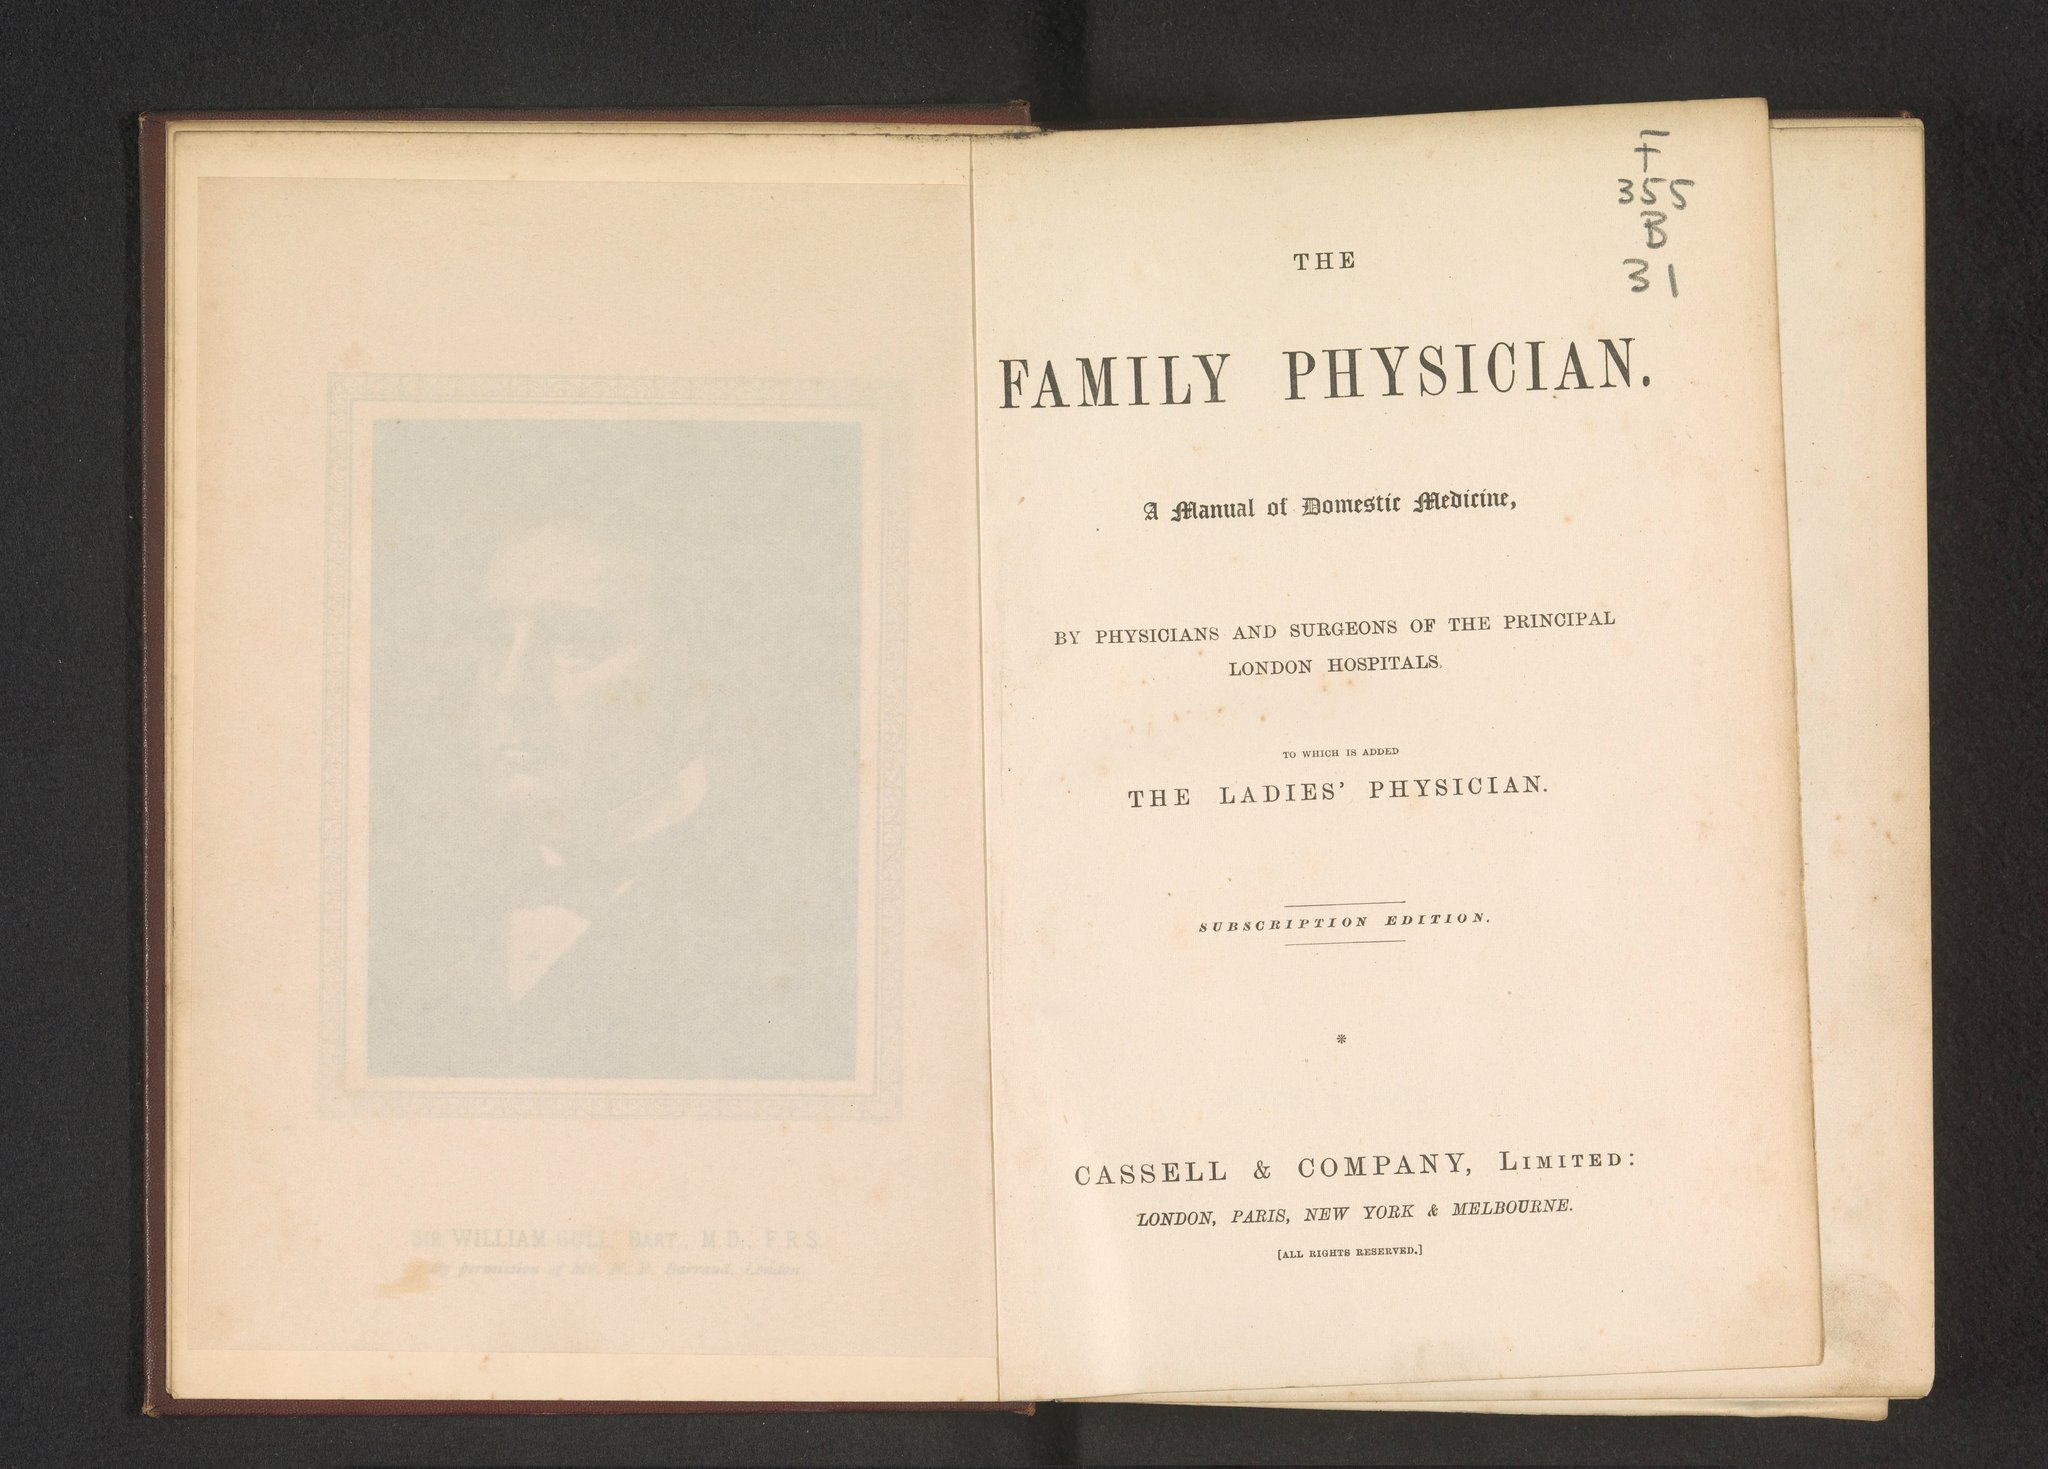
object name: book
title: The family physician volume I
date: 1890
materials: linen, paper, wood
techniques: lithograph, printing, woodburytype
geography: london